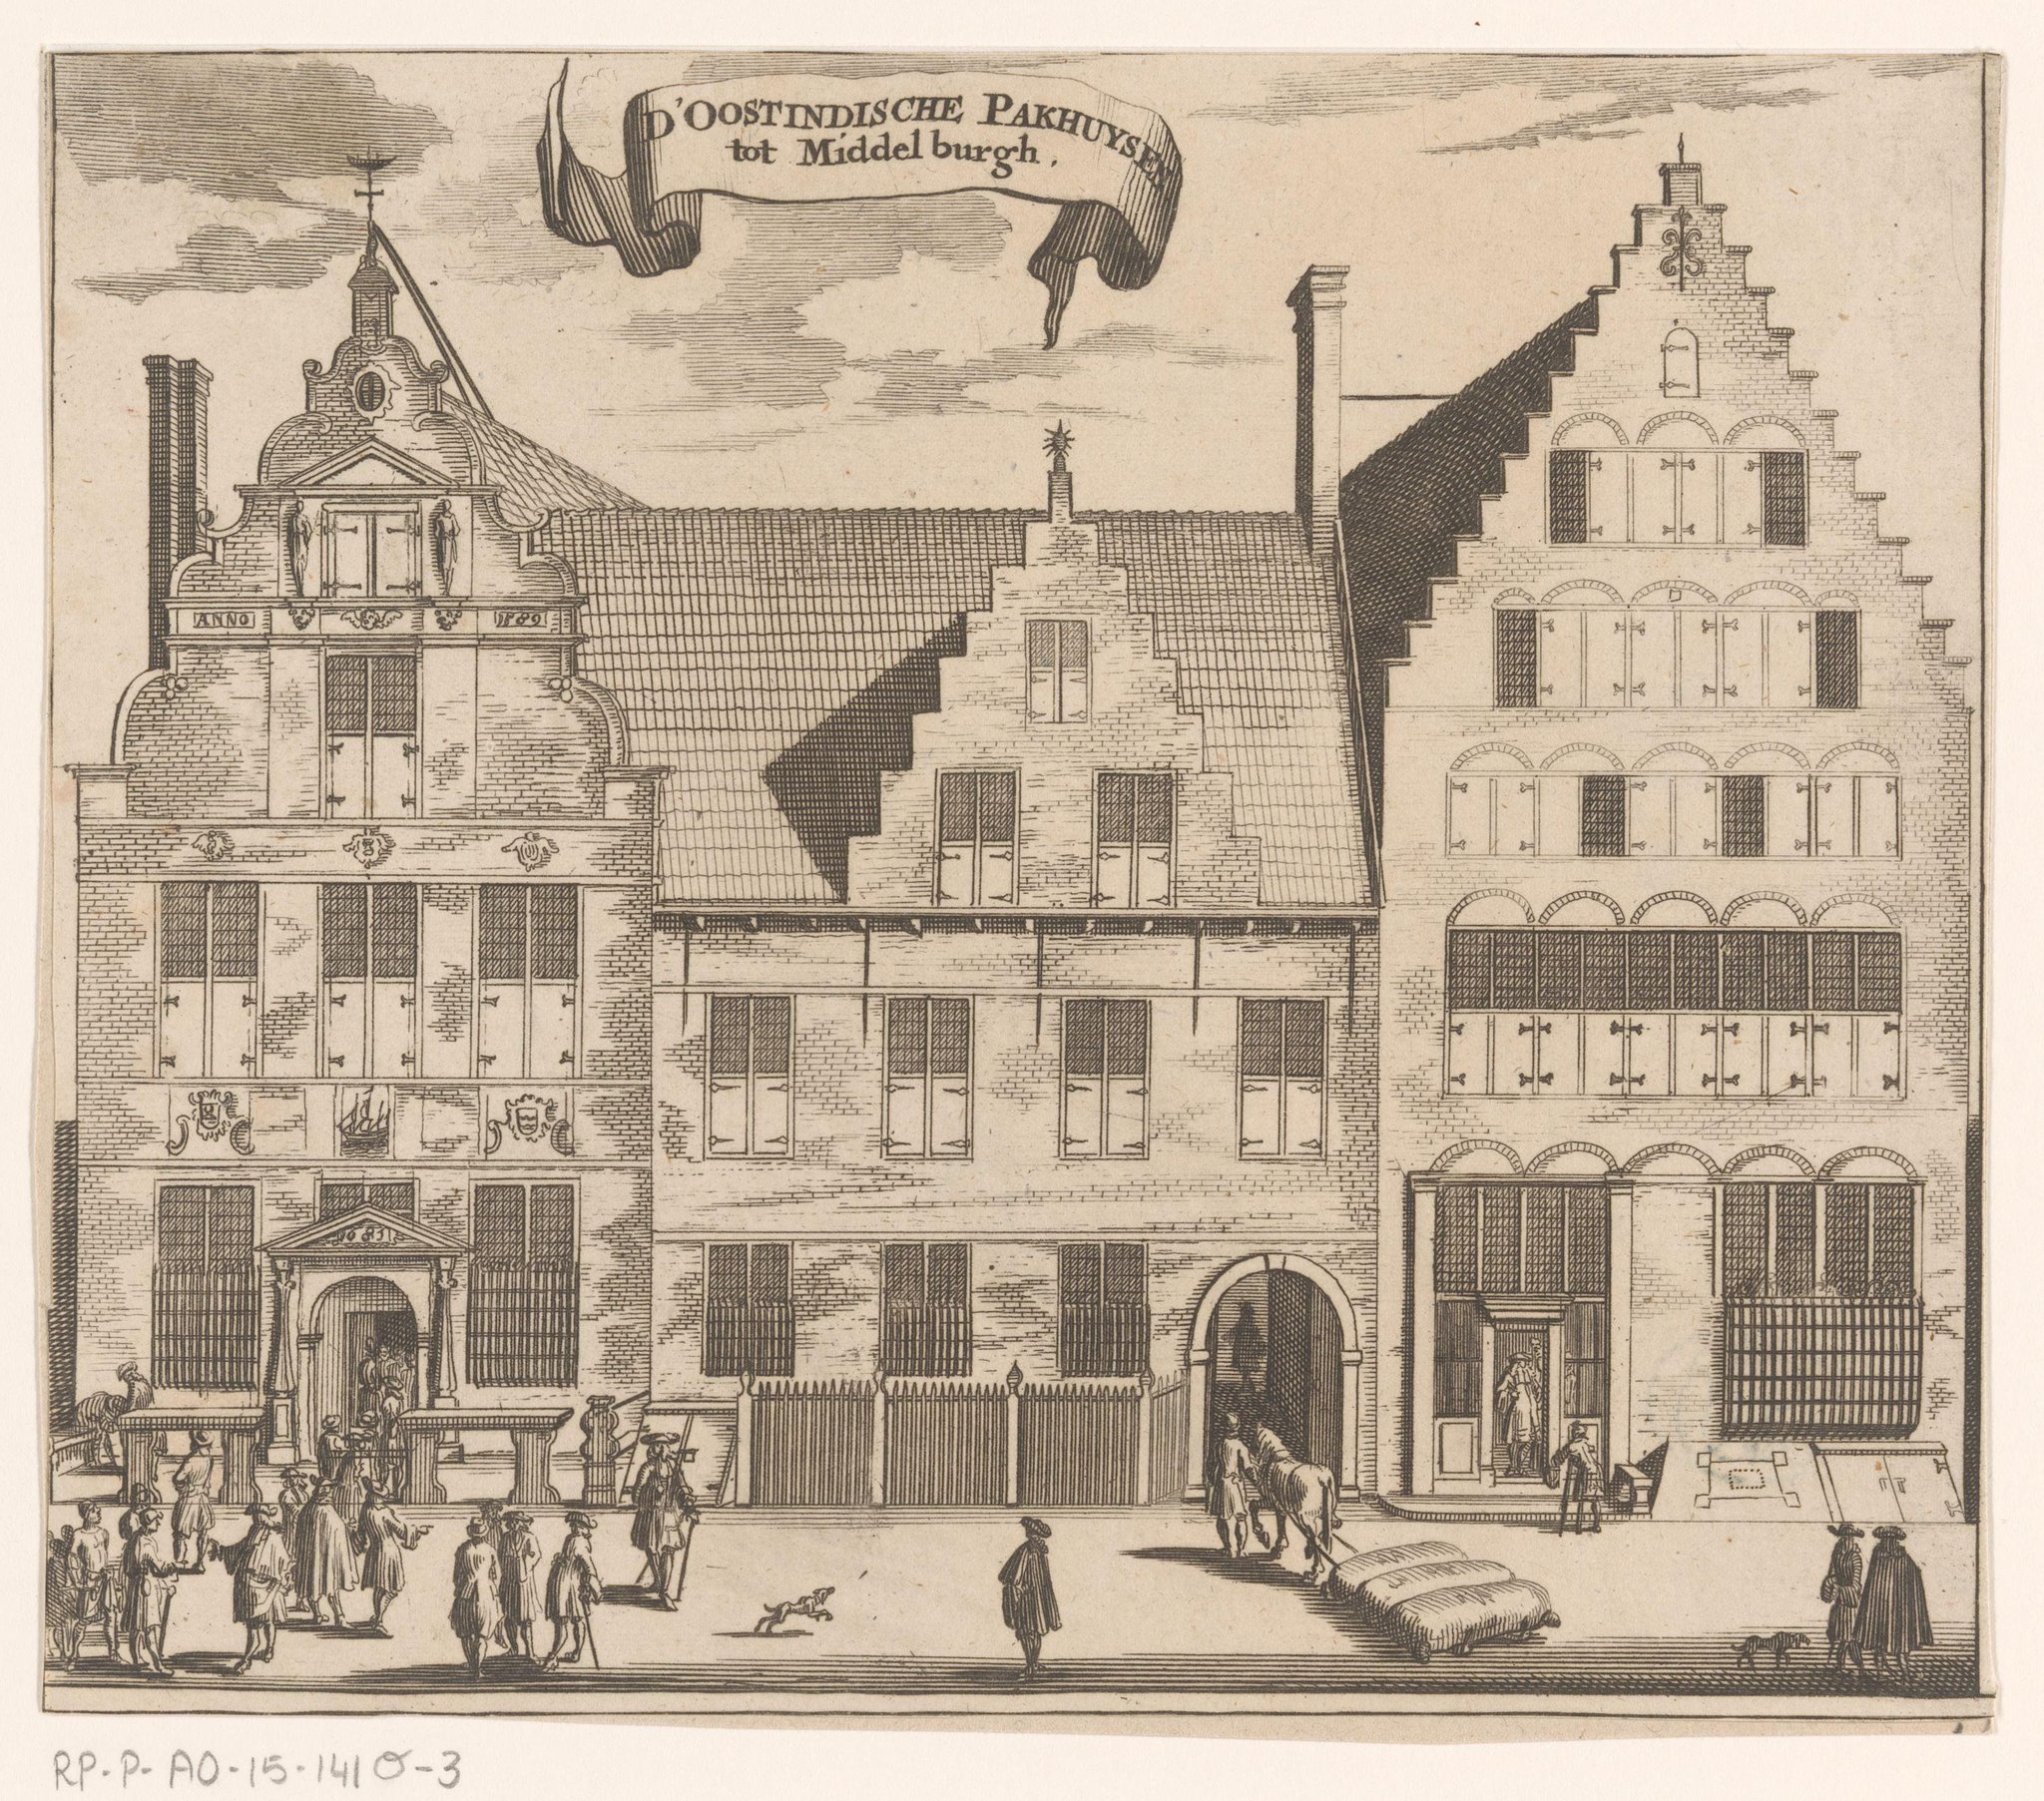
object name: print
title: Gezicht op de Oost-Indische Pakhuizen te Middelburg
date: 1696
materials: paper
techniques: engraving, etching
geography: middelburg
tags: warehouse (~ harbour), trade-company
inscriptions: collector's mark: Lugt 195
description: Oorspronkelijk van één plaat gedrukt met twee andere voorstellingen (zie RP-P-AO-15-141O-2 en RP-P-AO-15-141O-4). Prent in zijn geheel ook gebruikt in: Smallegange, Mattheus. Nieuwe Cronyk van Zeeland (…). Middelburg en Amsterdam: Johannes Meertens en Abraham van Someren, 1696. Huidige voorstelling later (plaat mogelijk versneden) met andere voorstelling van zelfde plaat en apart gedrukte sierrand ook gebruikt in: Aa, Pieter van der. La galerie agreable du monde (...). 66 delen. Leiden: Pieter van der Aa, 1728, dl. 20.